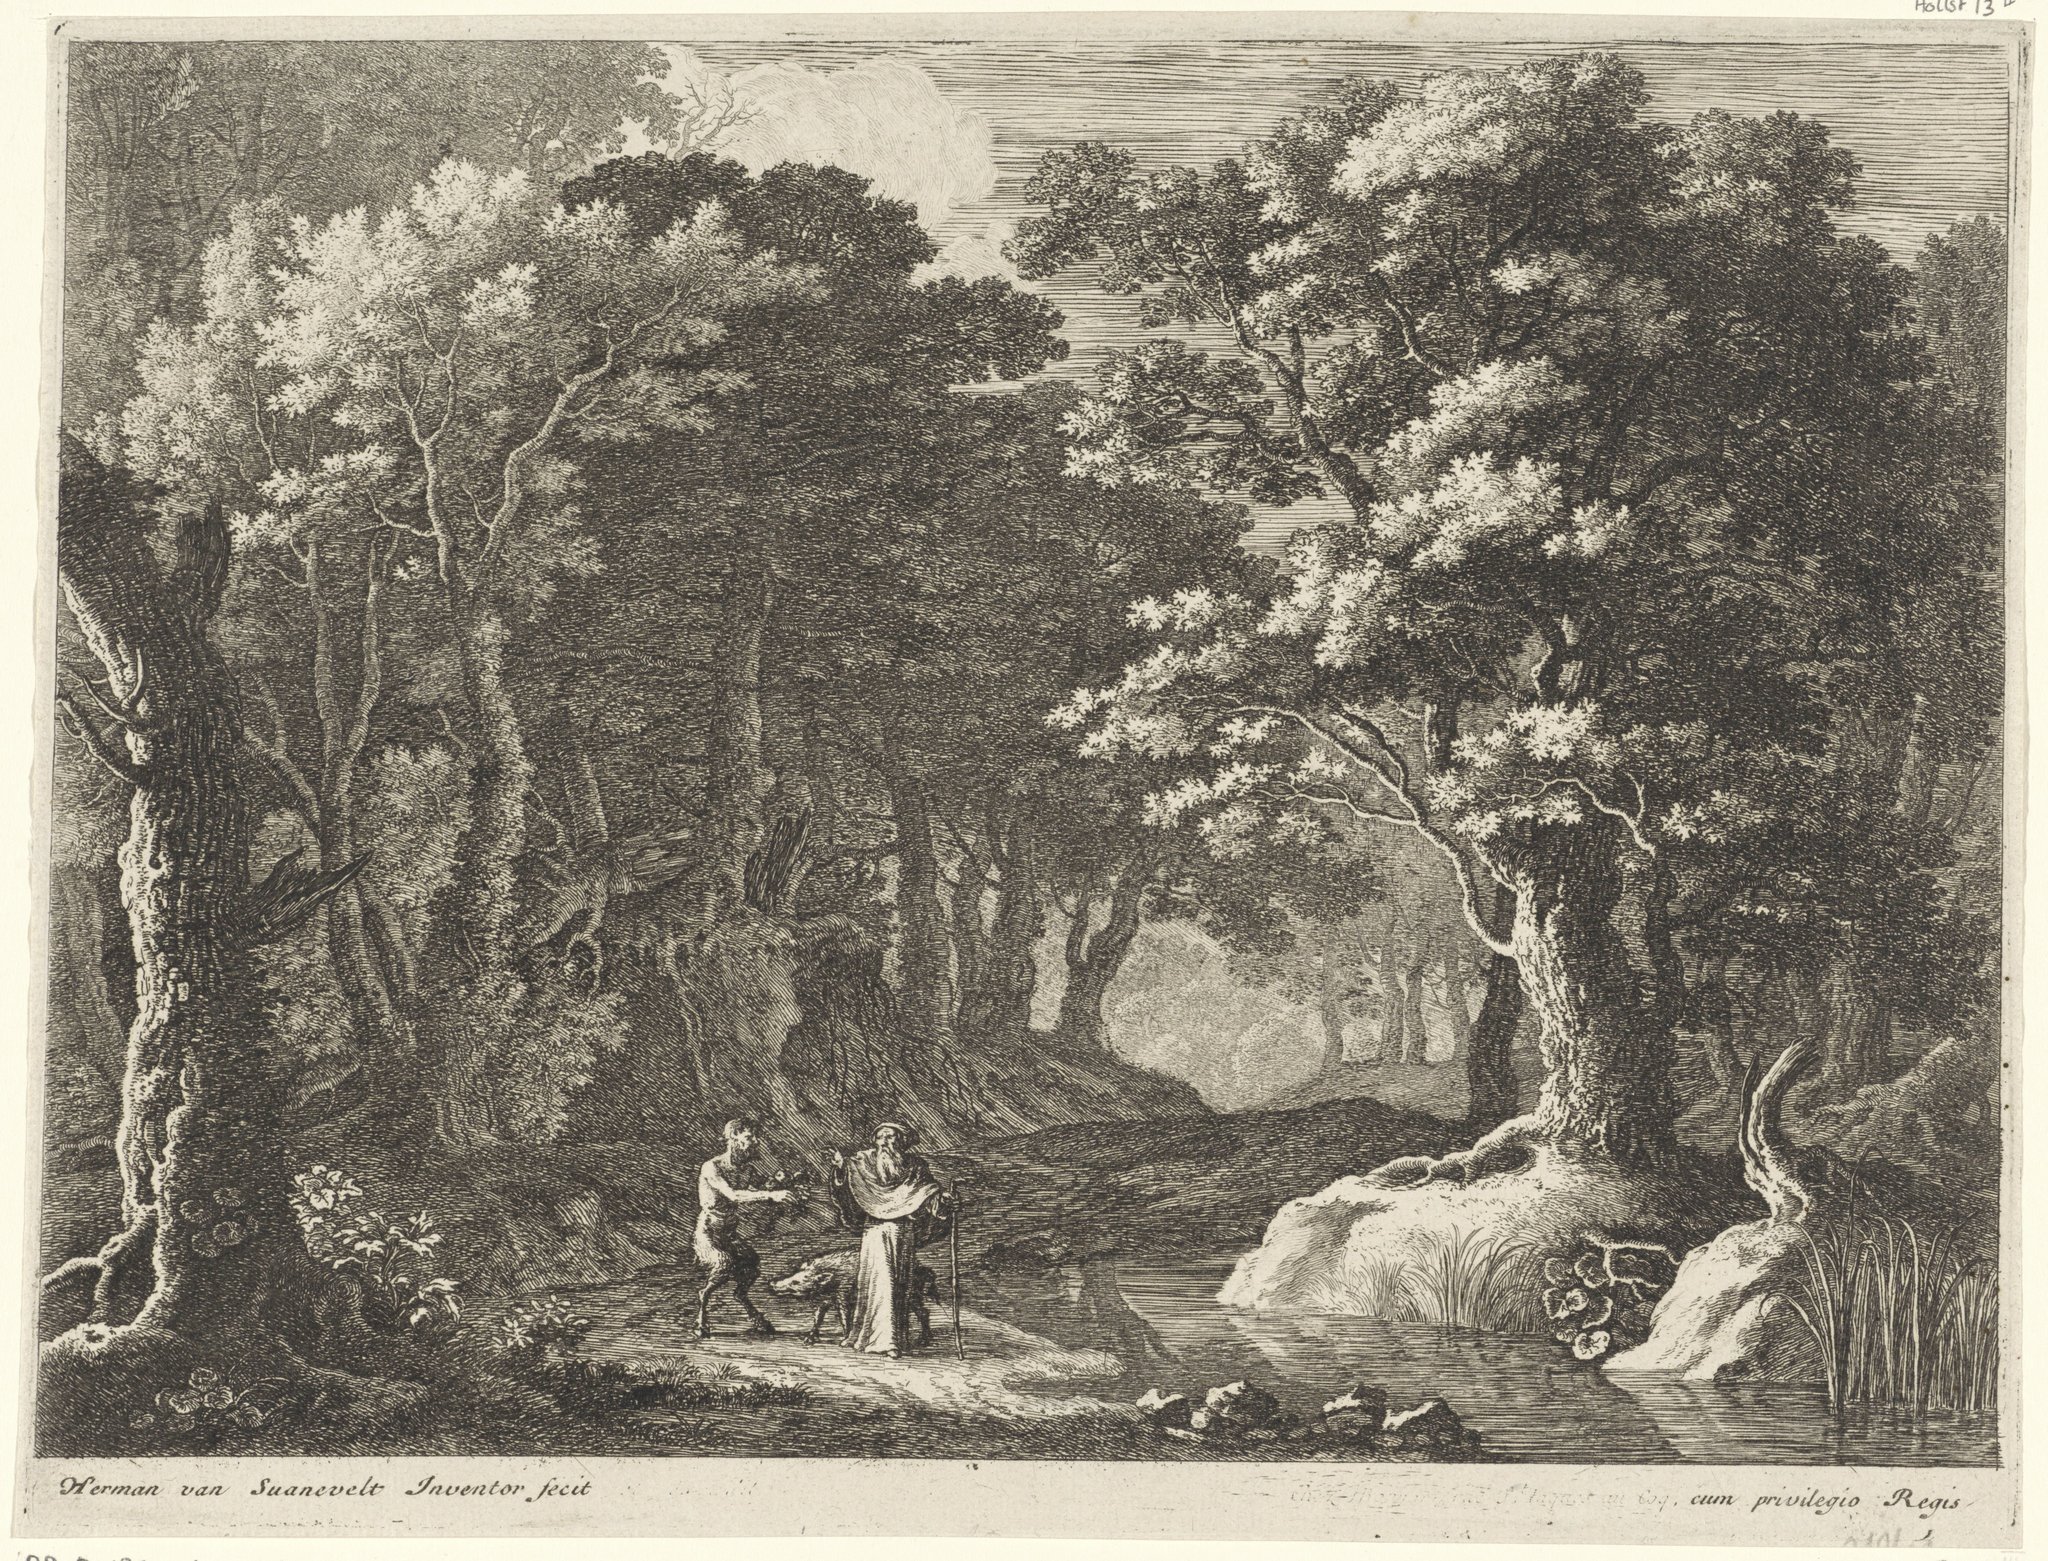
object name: print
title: Verzoeking van de H. Antonius de Grote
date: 1643-1655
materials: paper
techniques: etching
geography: paris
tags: temptations of st. antony abbot, satyr(s) (in general)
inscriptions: collector's mark: Lugt 2228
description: In een bosrijk landschap staat de heilige Antonius bij een rivier. Hij draagt een monnikspij en -kap. In zijn linkerhand houdt hij een stok met een tau en naast zijn rechterbeen is een varken, zijn attribuut, afgebeeld. Voor hem staat Satan met de uiterlijke kenmerken van een sater, die hem vruchten aanbiedt.